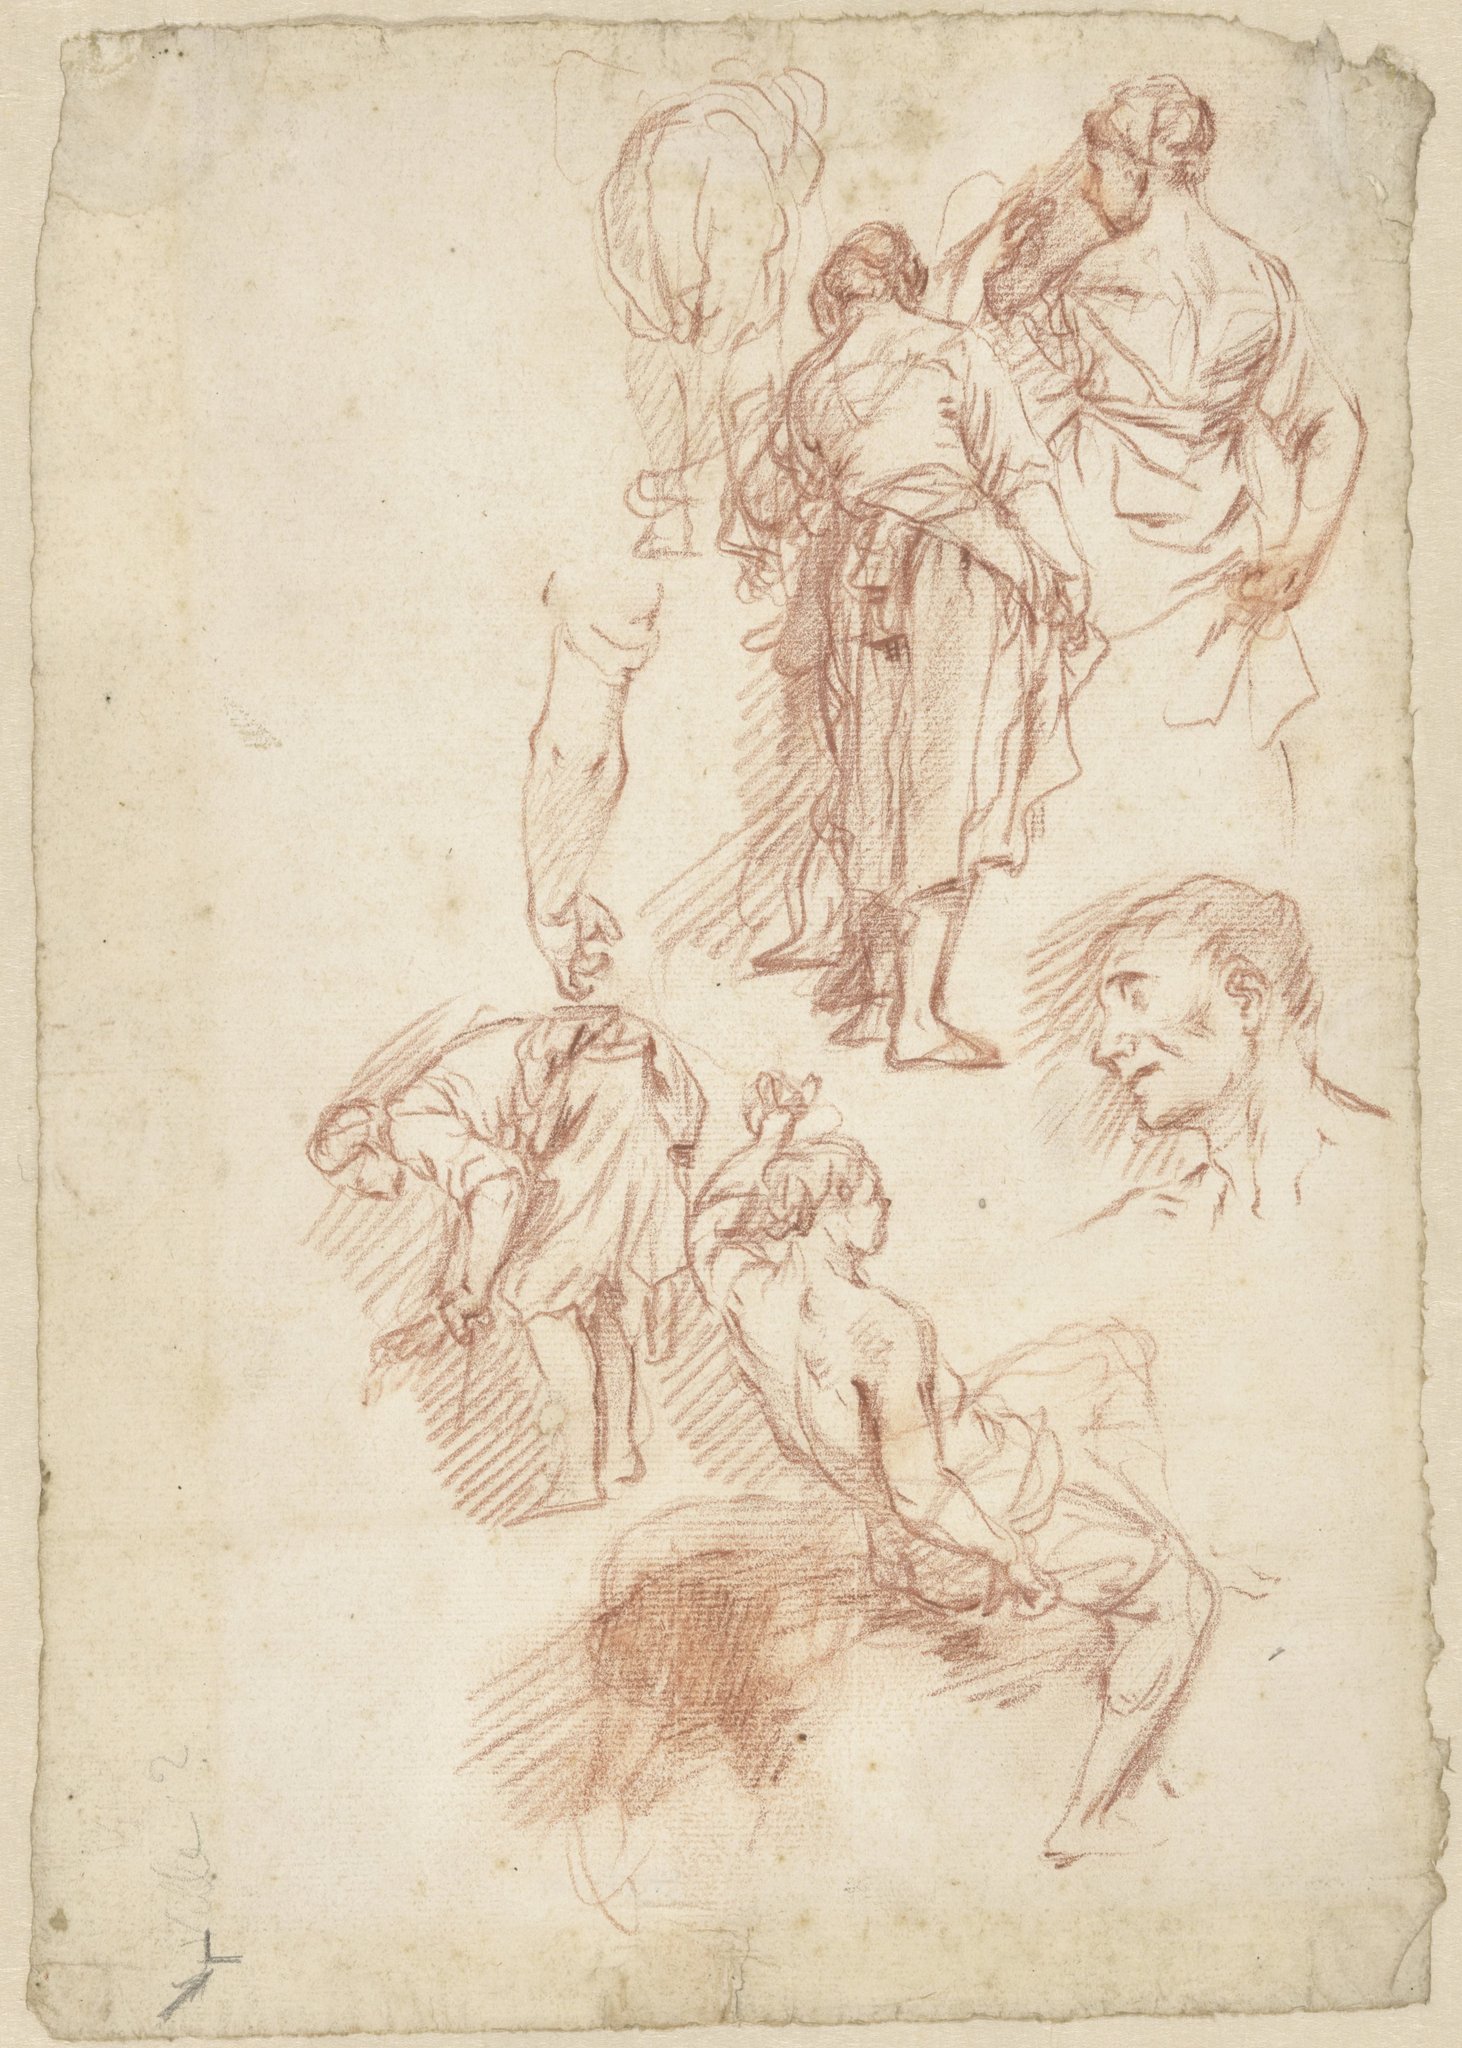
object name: drawing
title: Figuurstudies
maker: Anonymous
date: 1700-1800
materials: chalk, paper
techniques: drawing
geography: france